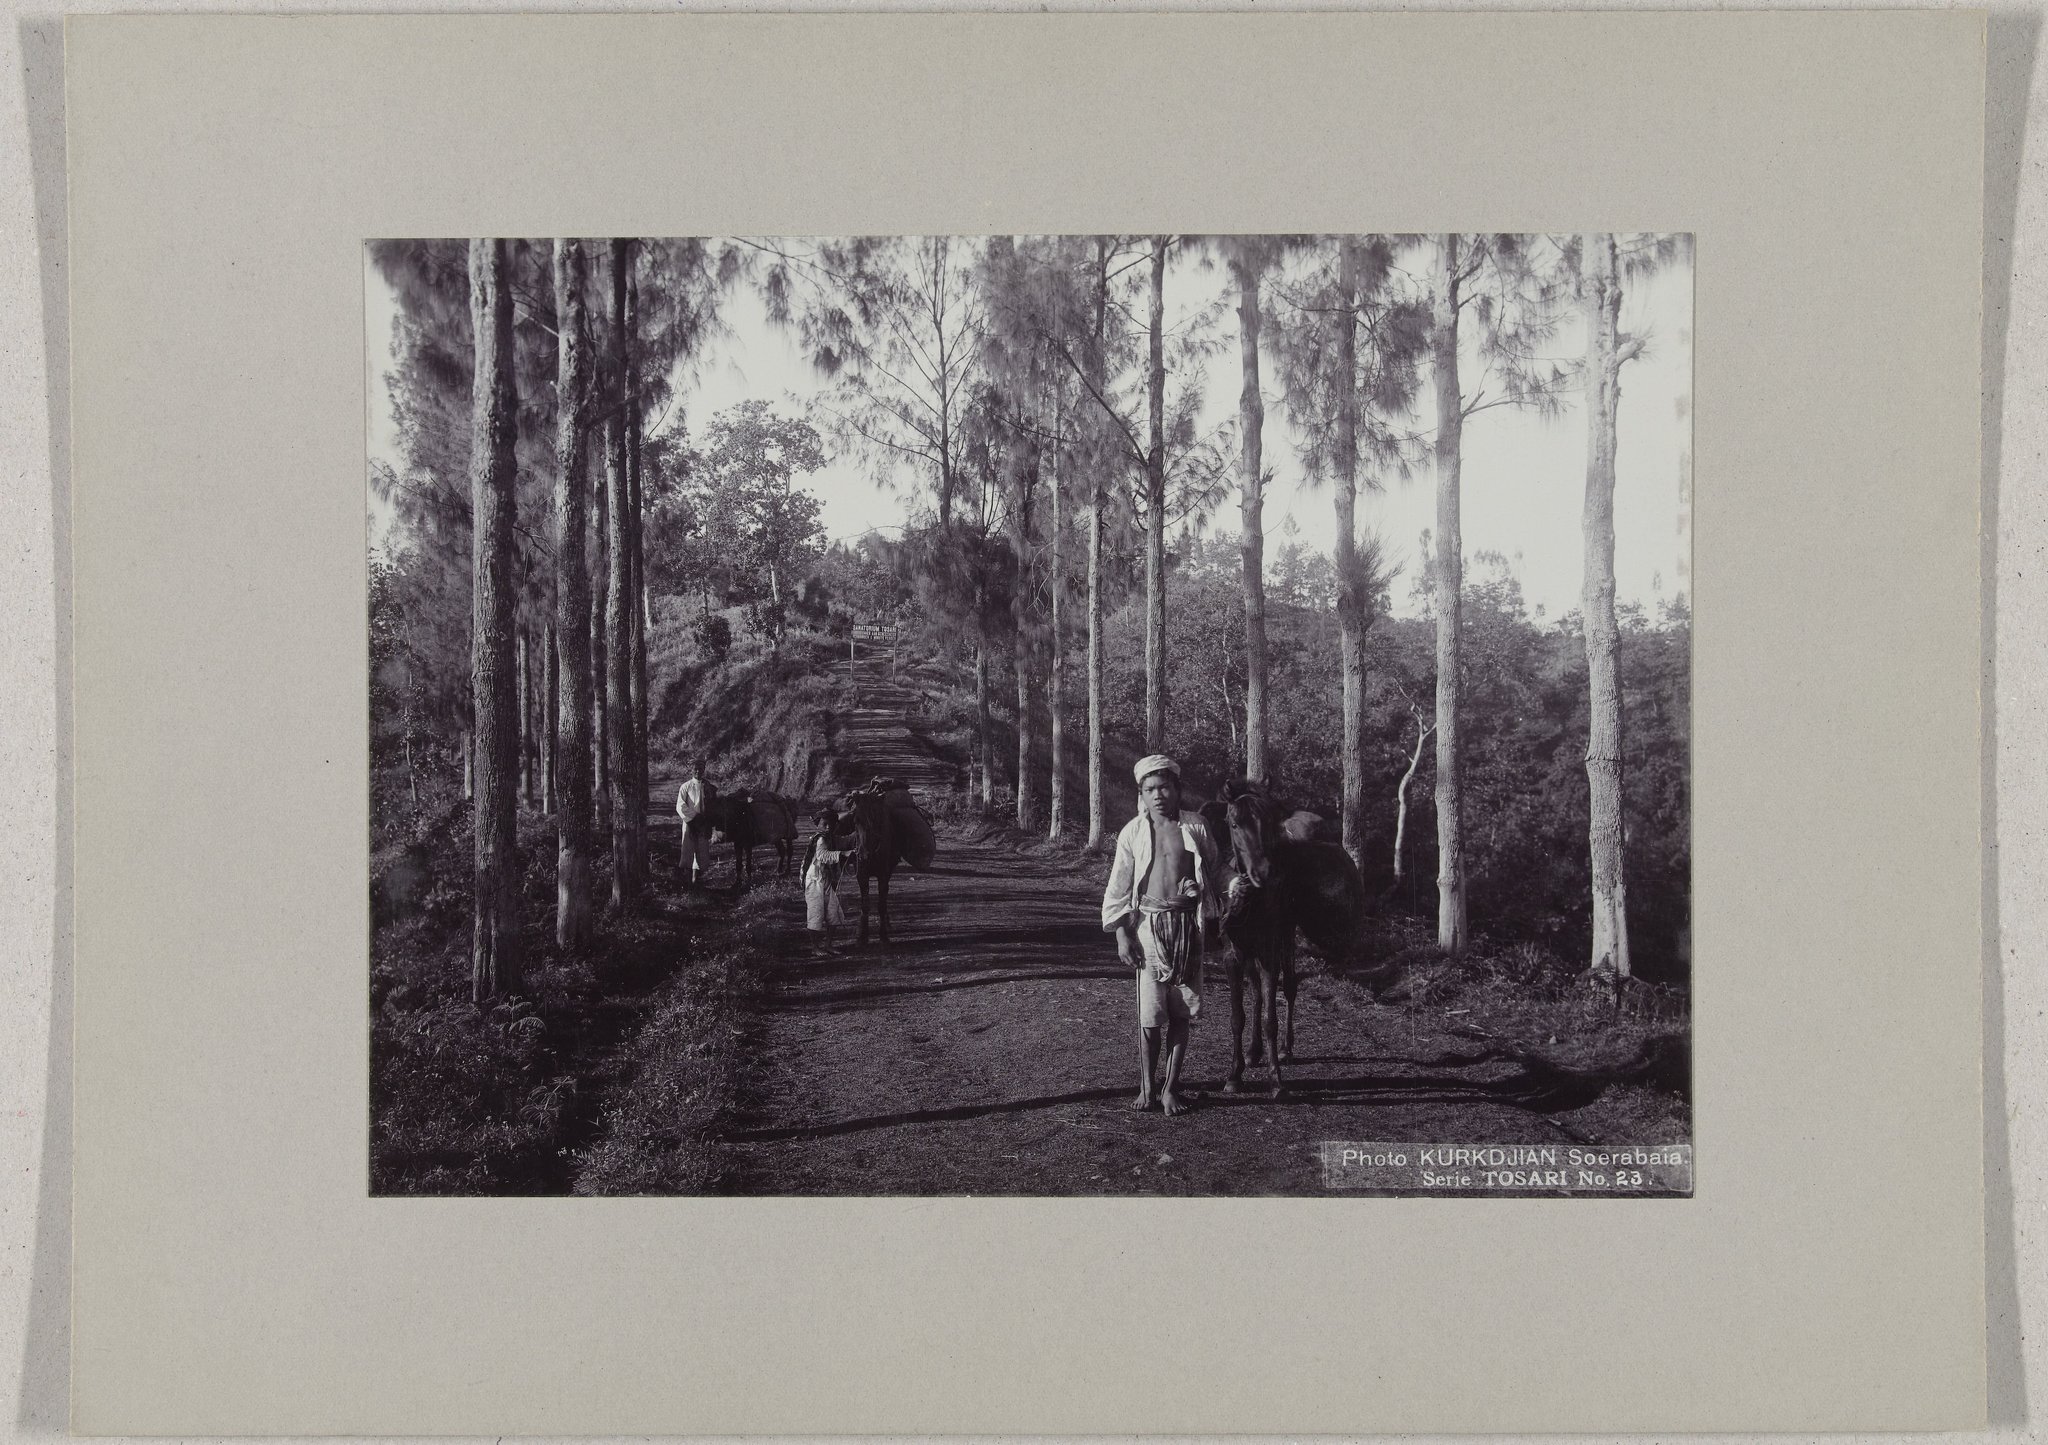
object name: photograph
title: Jongens met paarden op een weg in Tosari, Tenggergebergte, Java, Nederlands-Indië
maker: onnes kurkdjian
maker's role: fotograaf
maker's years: 1851-1903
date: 1895-1915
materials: cardboard, paper, photographic support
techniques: gelatin silver print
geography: java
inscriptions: name: ‘Photo Kurkdjian Soerabaia / Serie Tosari No. 23’, number: ‘95’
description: Jongens met paarden op een weg in Tosari, Tenggergebergte, Java, Nederlands-Indië